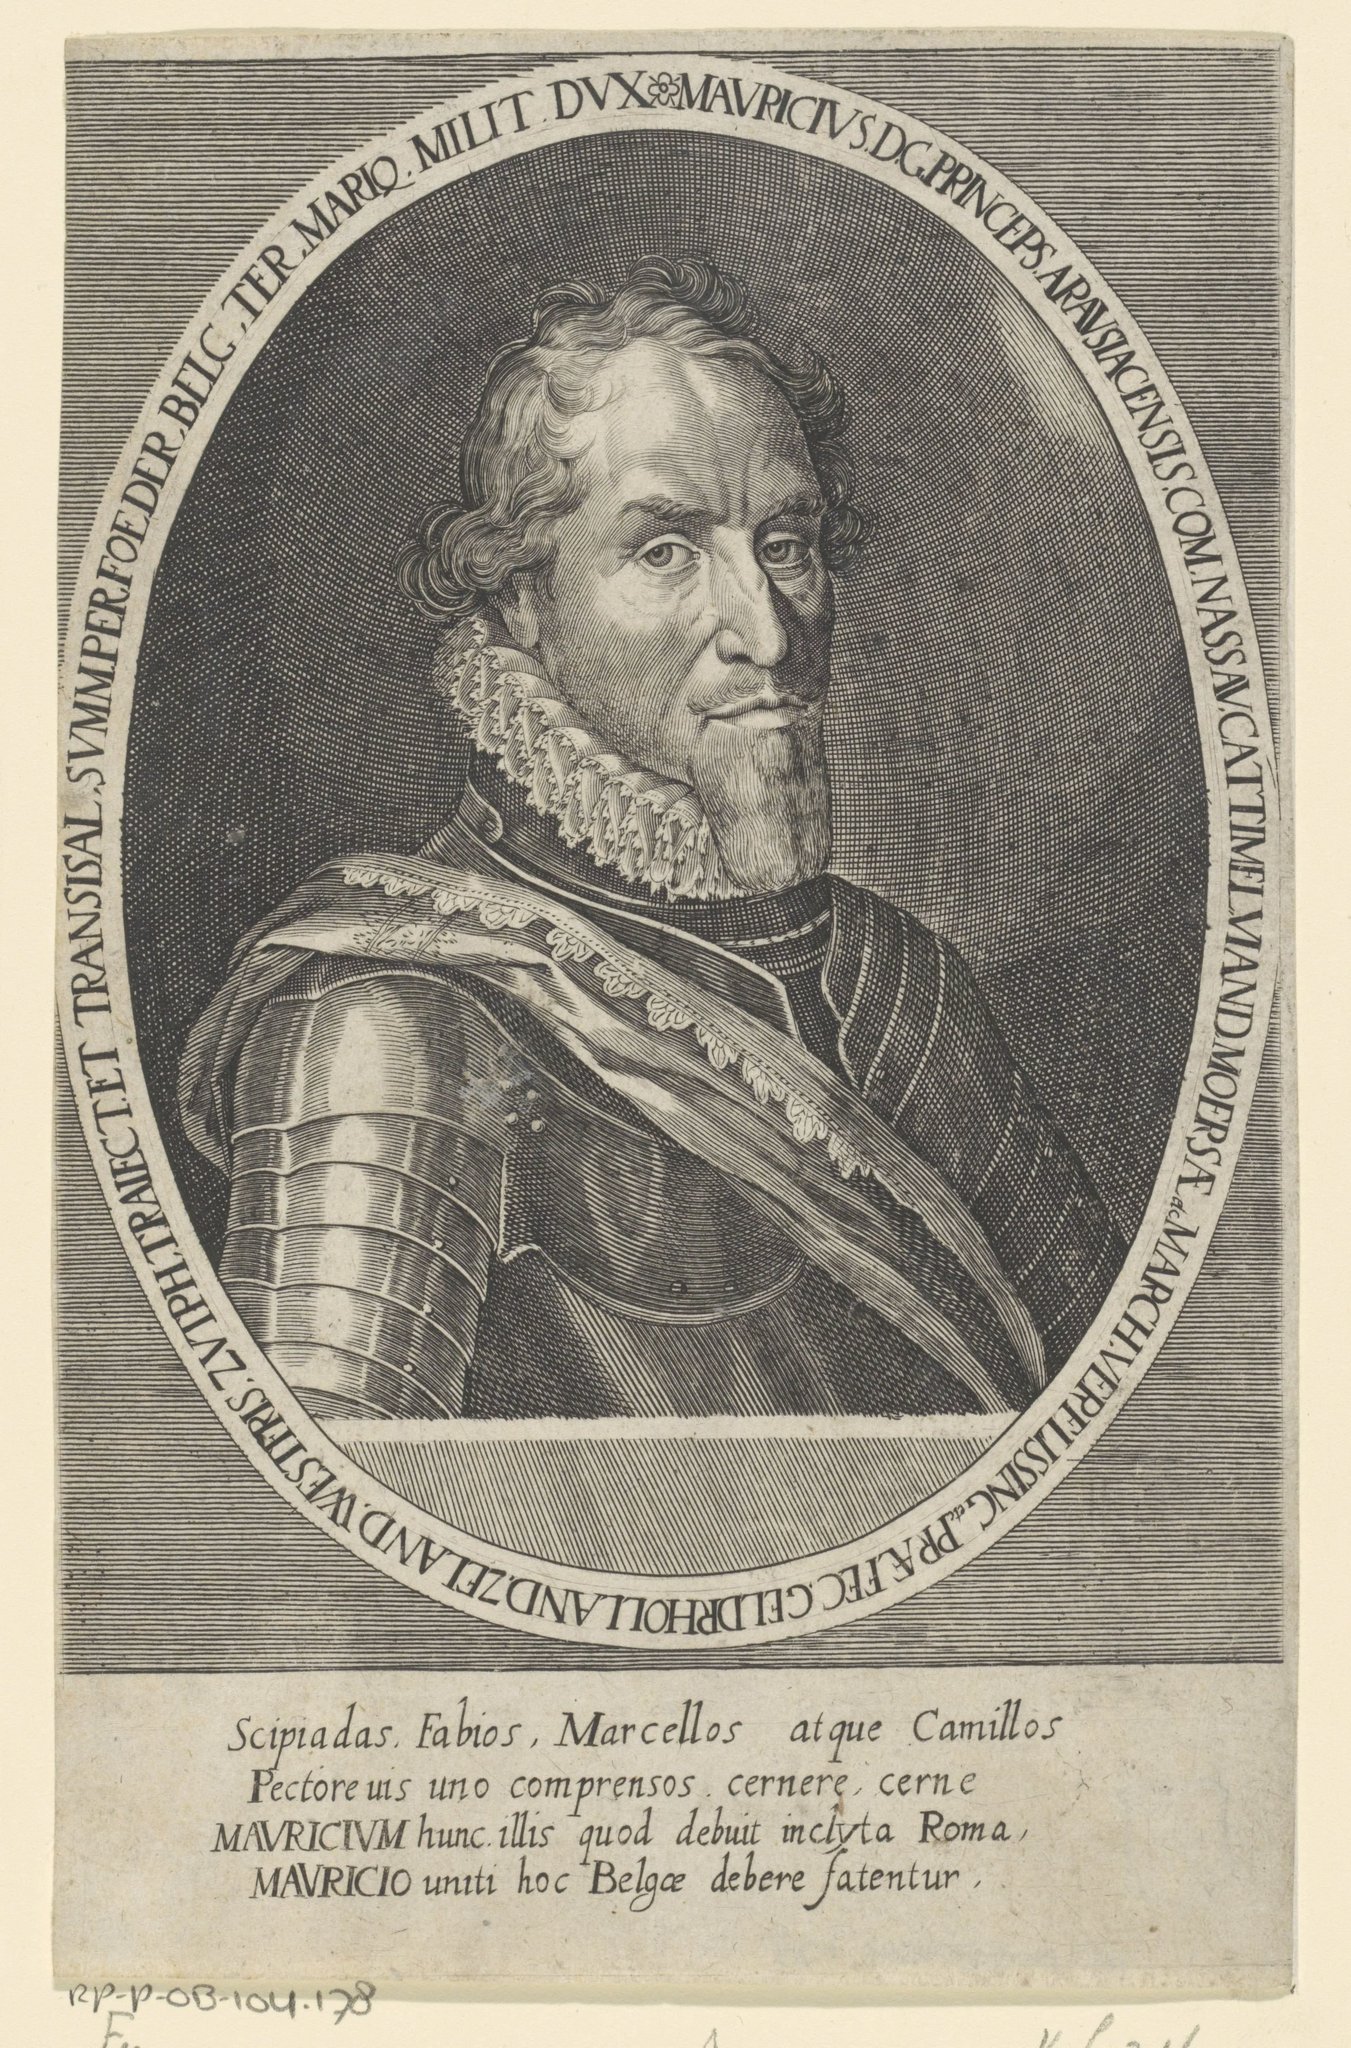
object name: print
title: Portret van Maurits, prins van Oranje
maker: Anonymous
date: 1600-1699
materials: paper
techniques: engraving, etching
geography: low countries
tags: the hague, maurice (prince of orange)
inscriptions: collector's mark: Lugt 963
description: De hier vermelde titel verwijst naar de hoogst verkregen titel van de geportretteerde, niet per se naar de titel die de geportretteerde op deze voorstelling draagt.